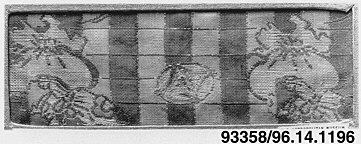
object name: piece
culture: japanese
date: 1701-1900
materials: silk